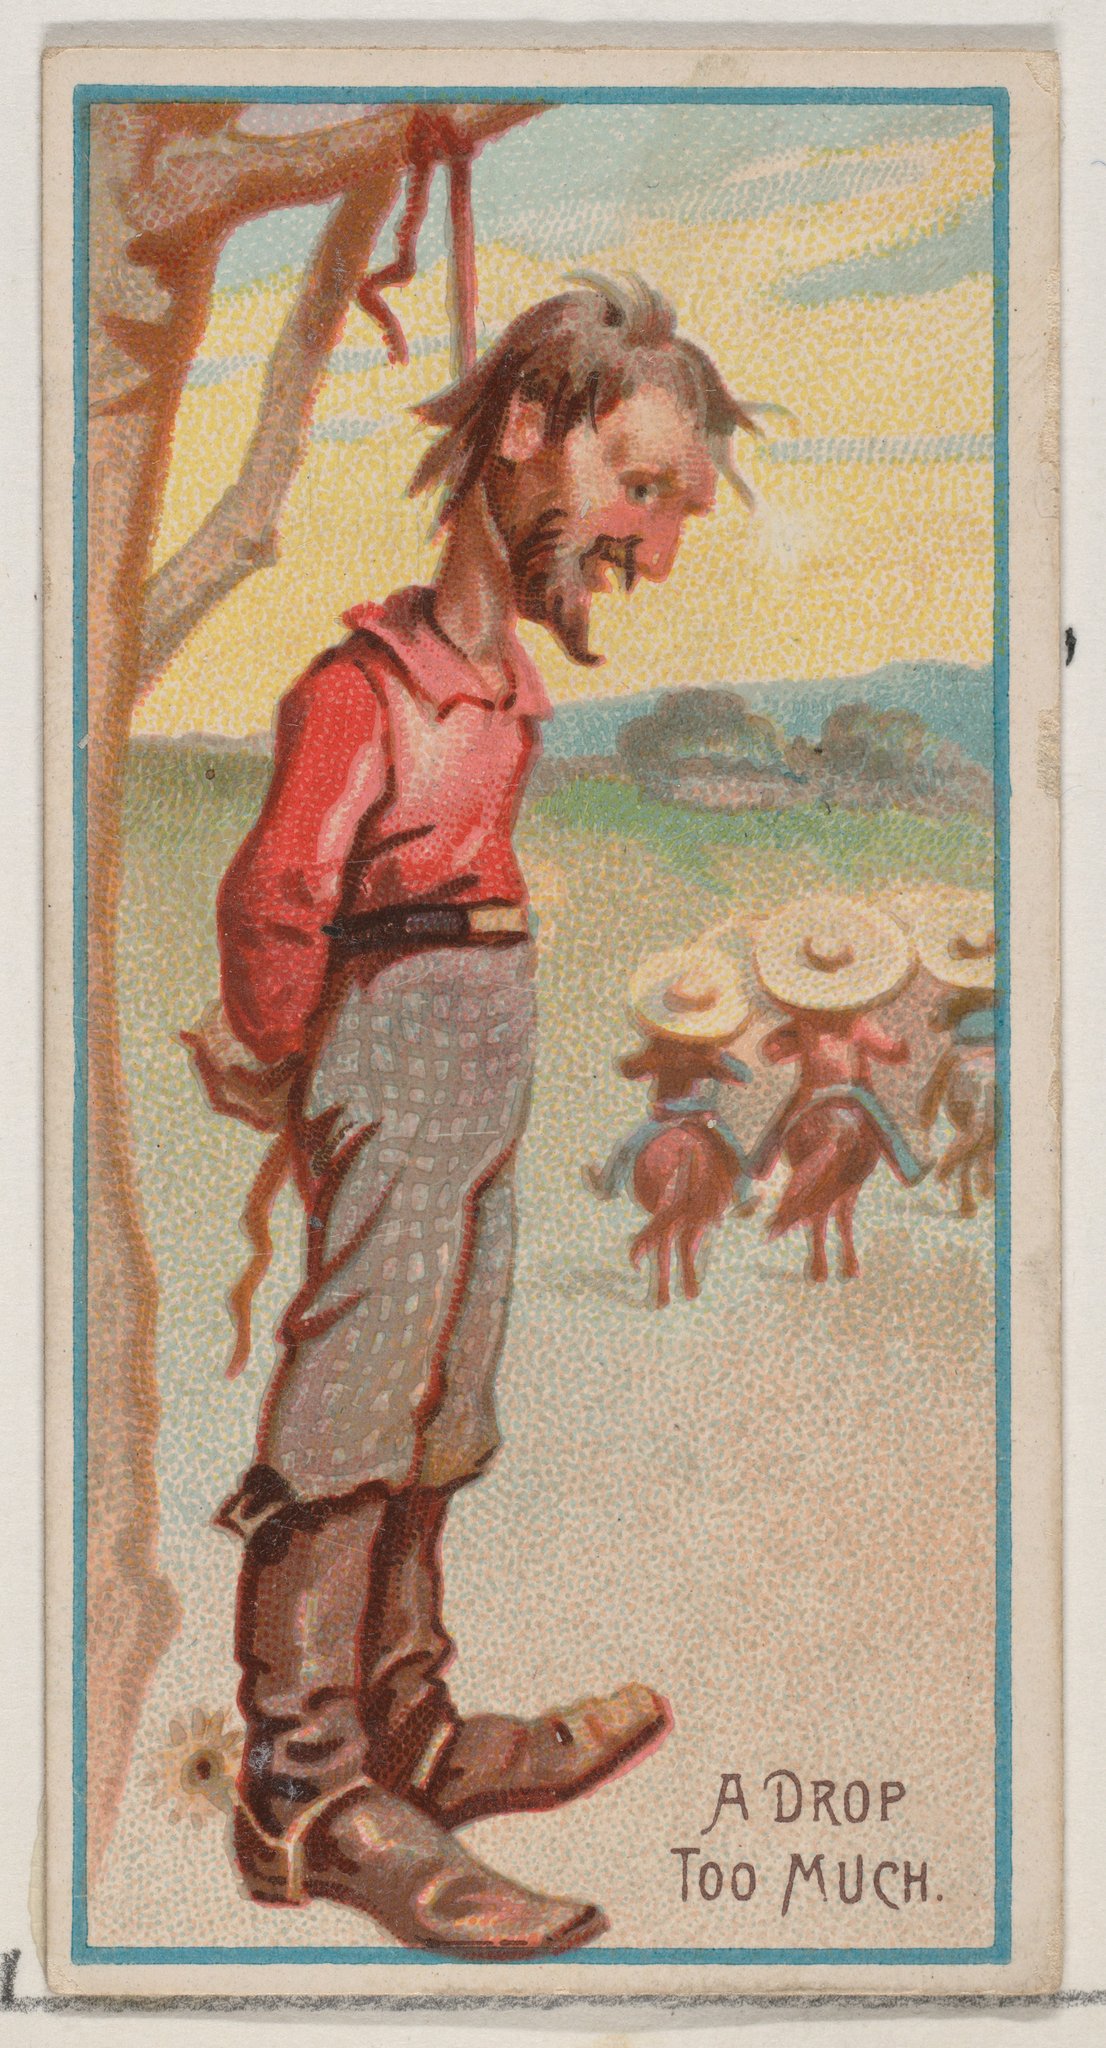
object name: print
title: A Drop Too Much, from the Jokes series (N87) for Duke brand cigarettes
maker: w. duke, sons & co.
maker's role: publisher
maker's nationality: american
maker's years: 1870-1920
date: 1890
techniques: color lithograph